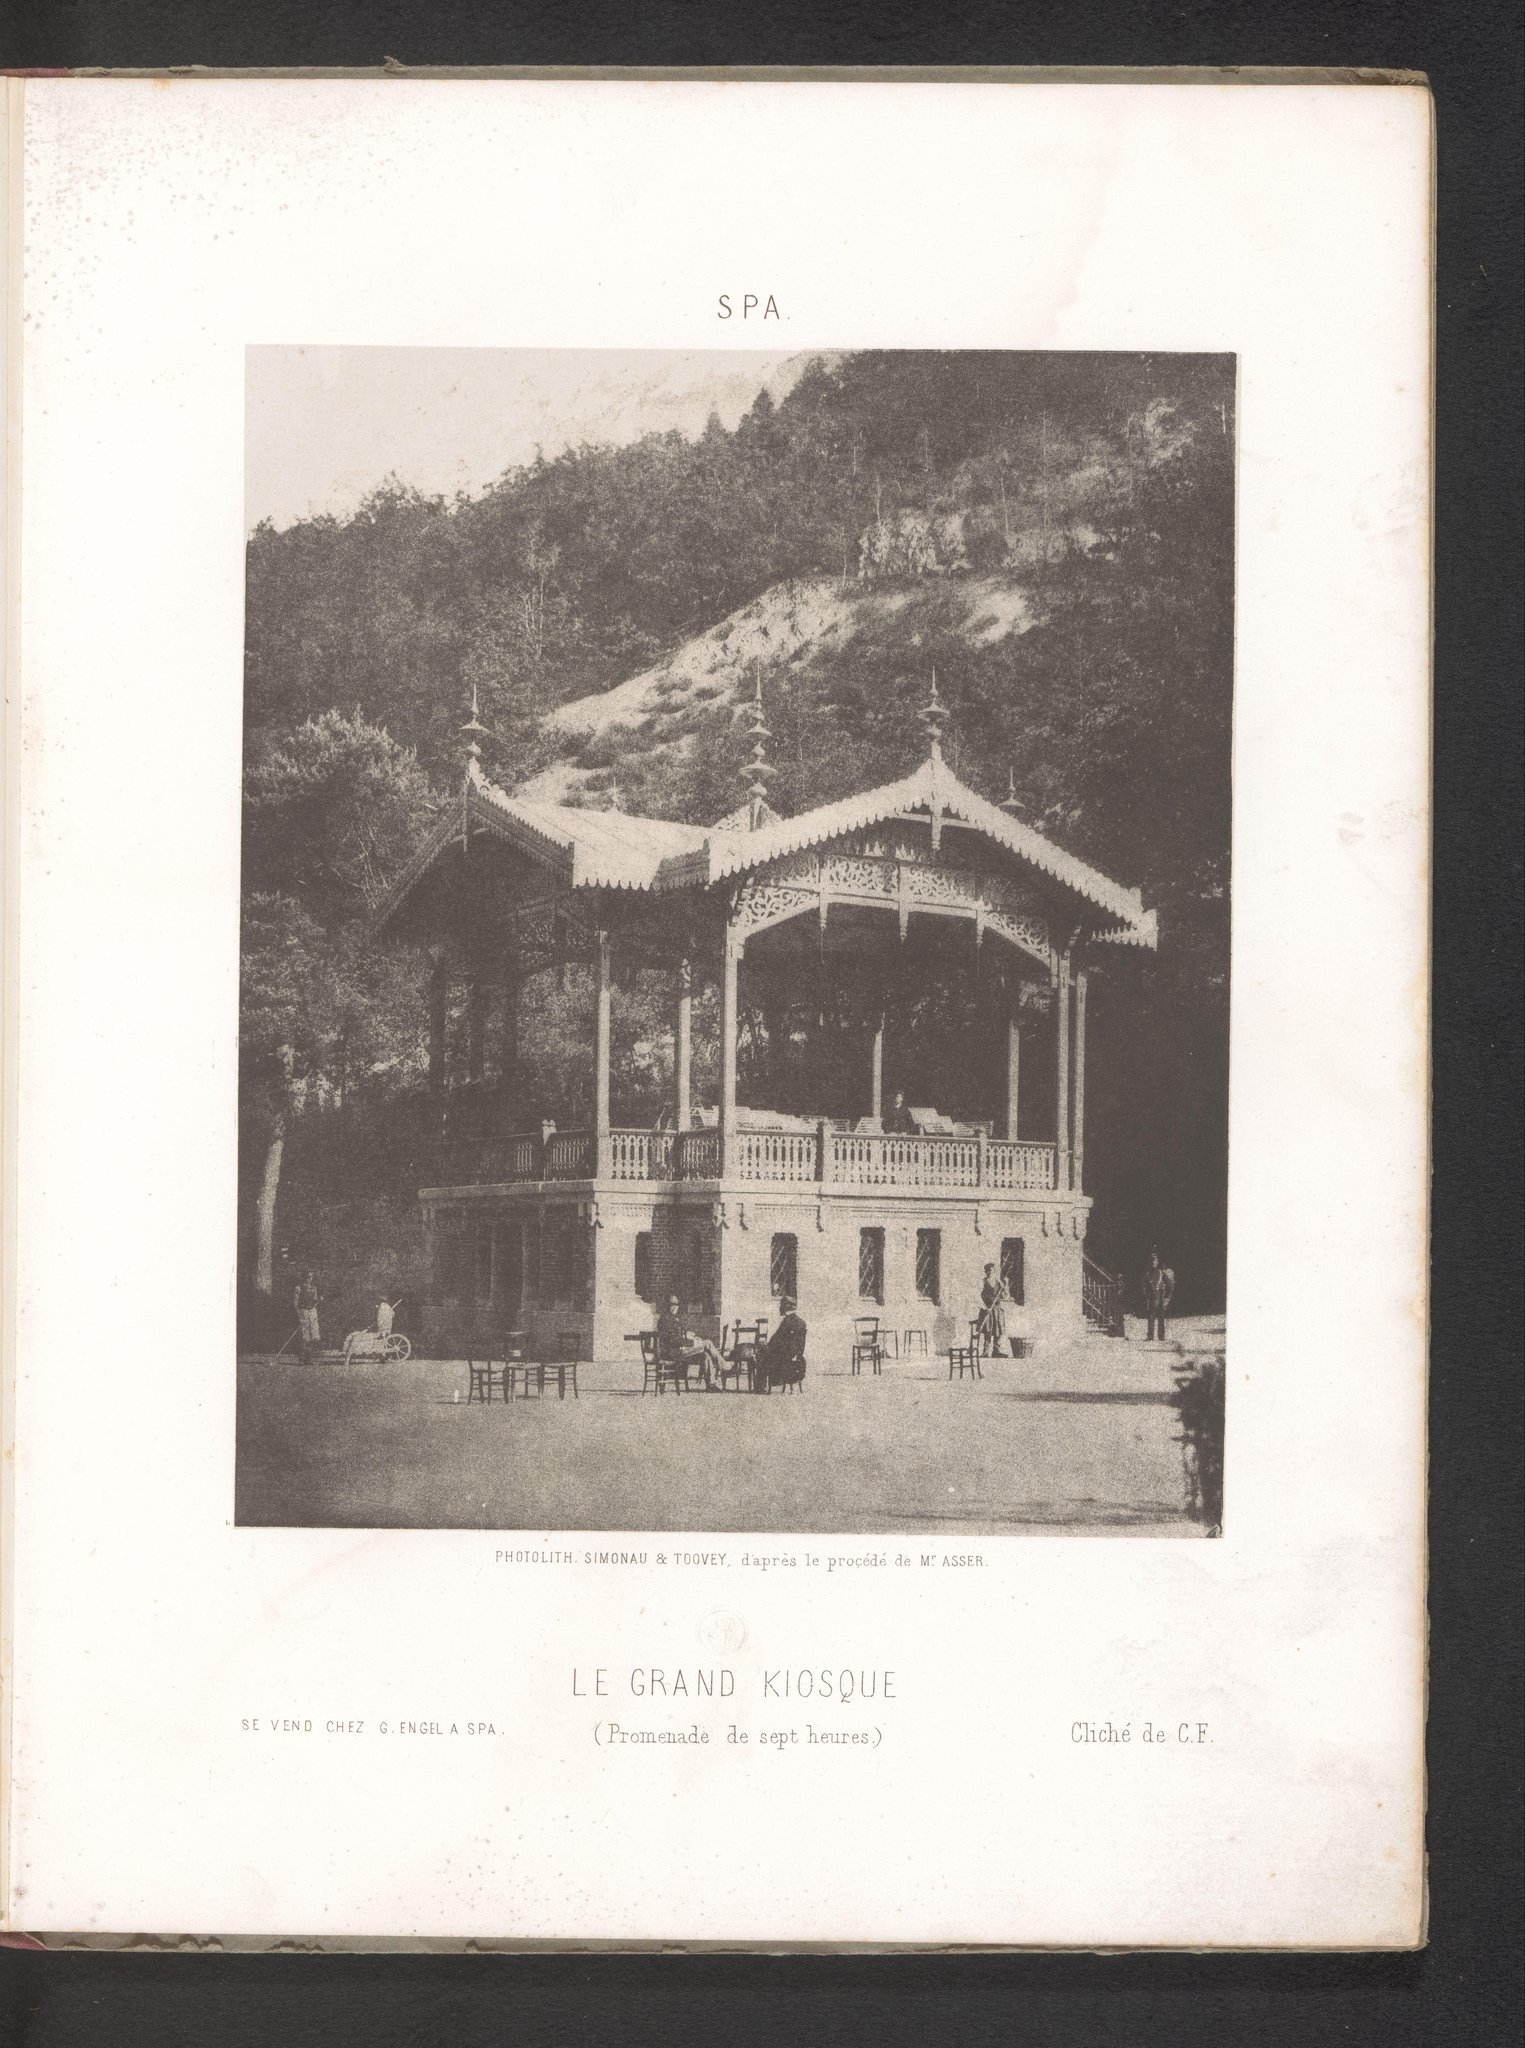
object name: page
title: Spa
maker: c.f.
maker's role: fotograaf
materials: paper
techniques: photolithography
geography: brussels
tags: park, bandstand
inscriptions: collector's mark: ‘EA’, inscription: ‘PHOTOLITH. SIMONAU & TOOVEY, d'après le procédé de Mr. ASSER.’, inscription: ‘SE VEND CHEZ F. ENGEL A SPA.’